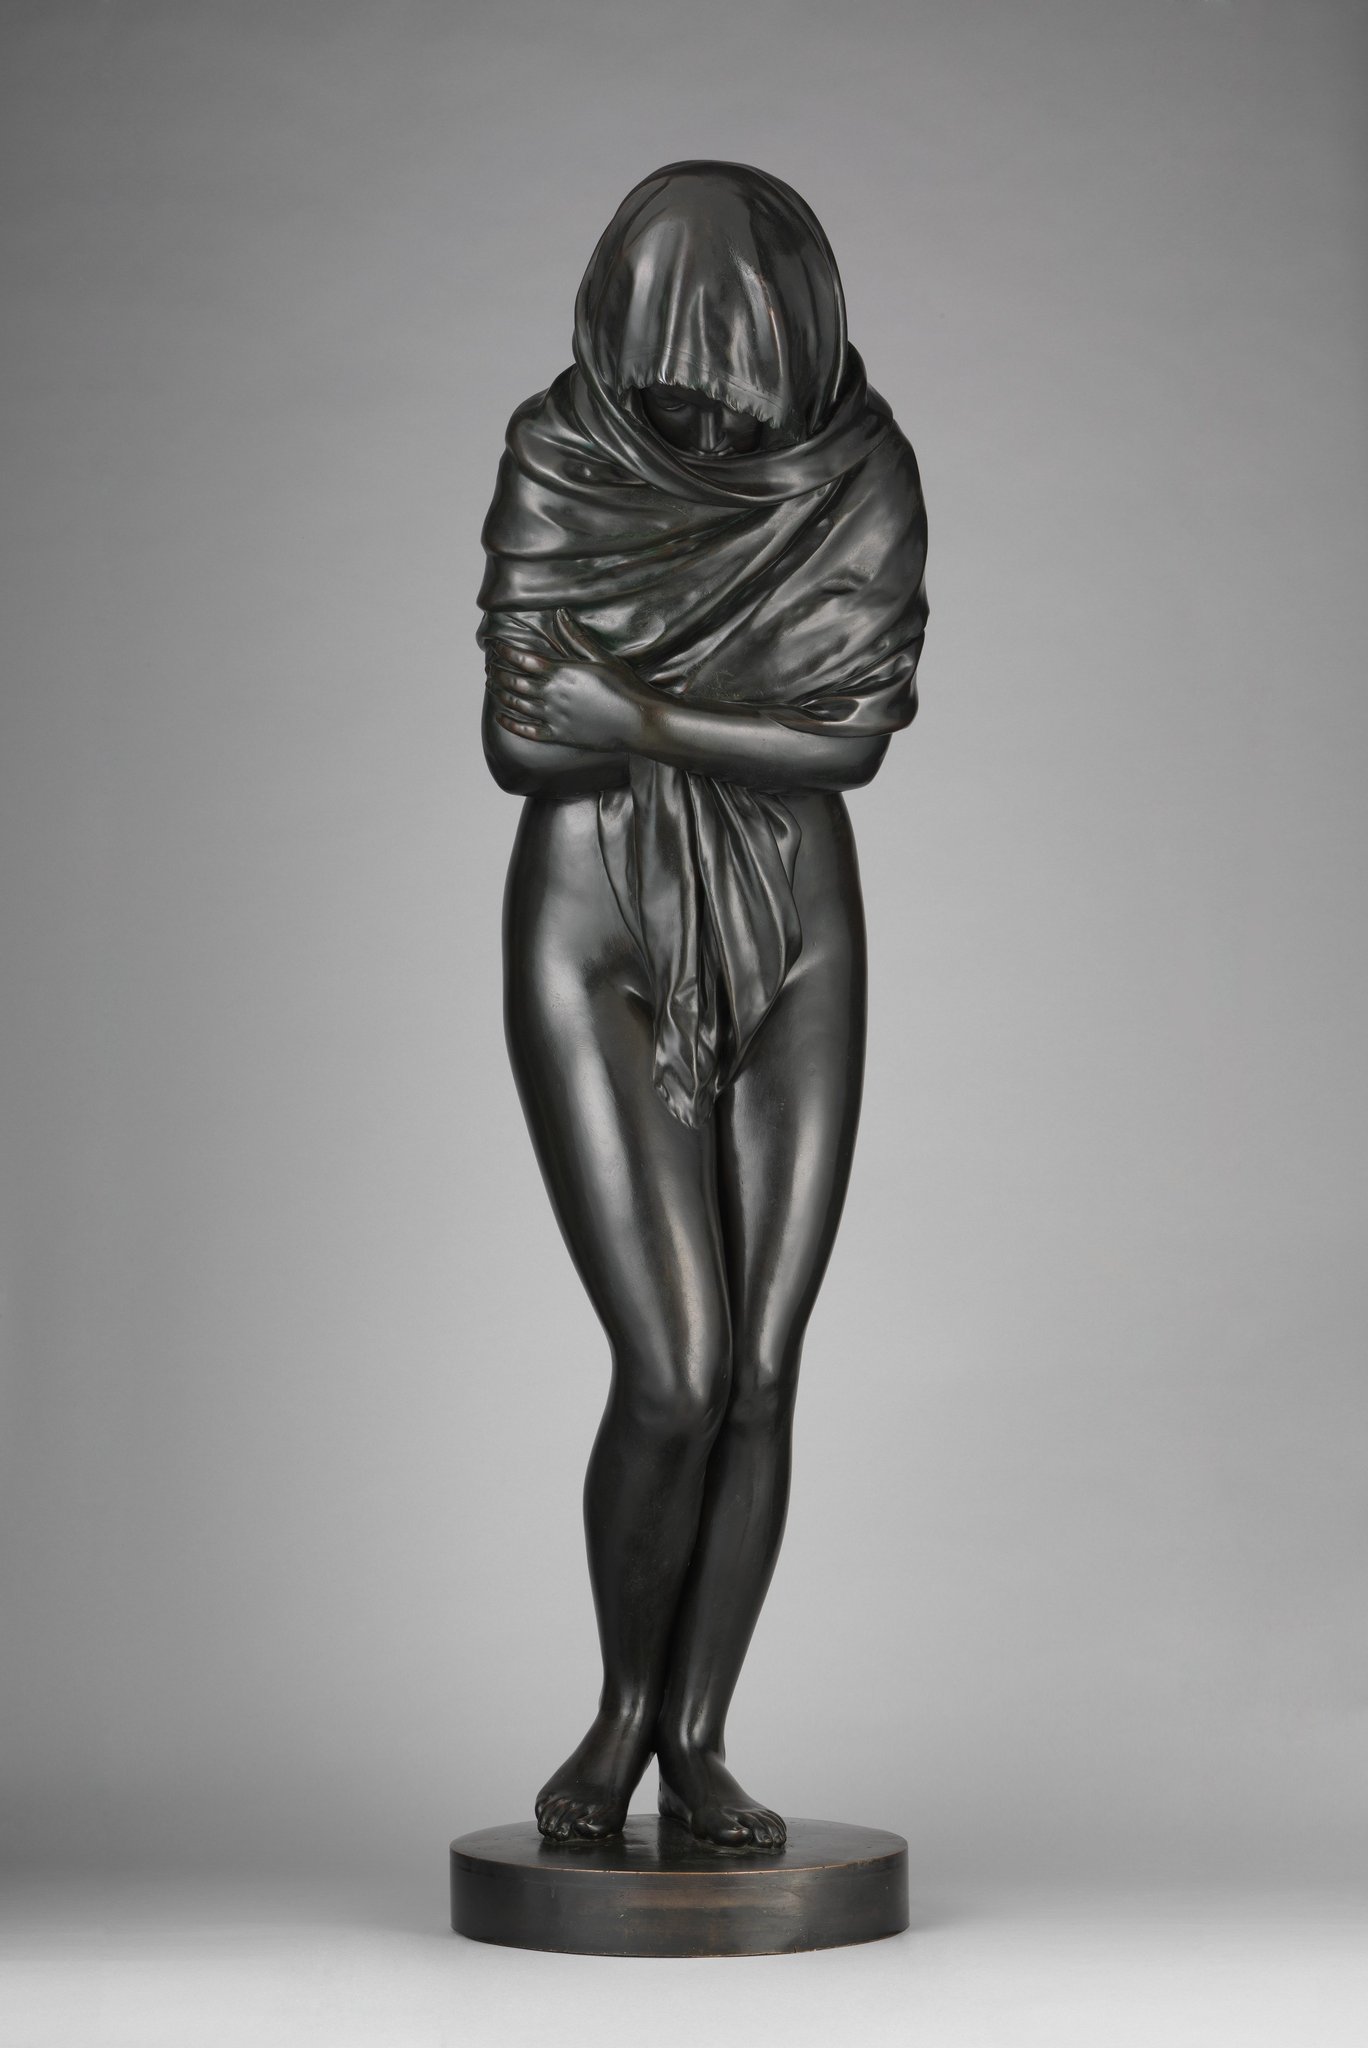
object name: statue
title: Winter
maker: jean antoine houdon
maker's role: artist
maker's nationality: french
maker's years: 1741-1828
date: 1787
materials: bronze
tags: female nudes